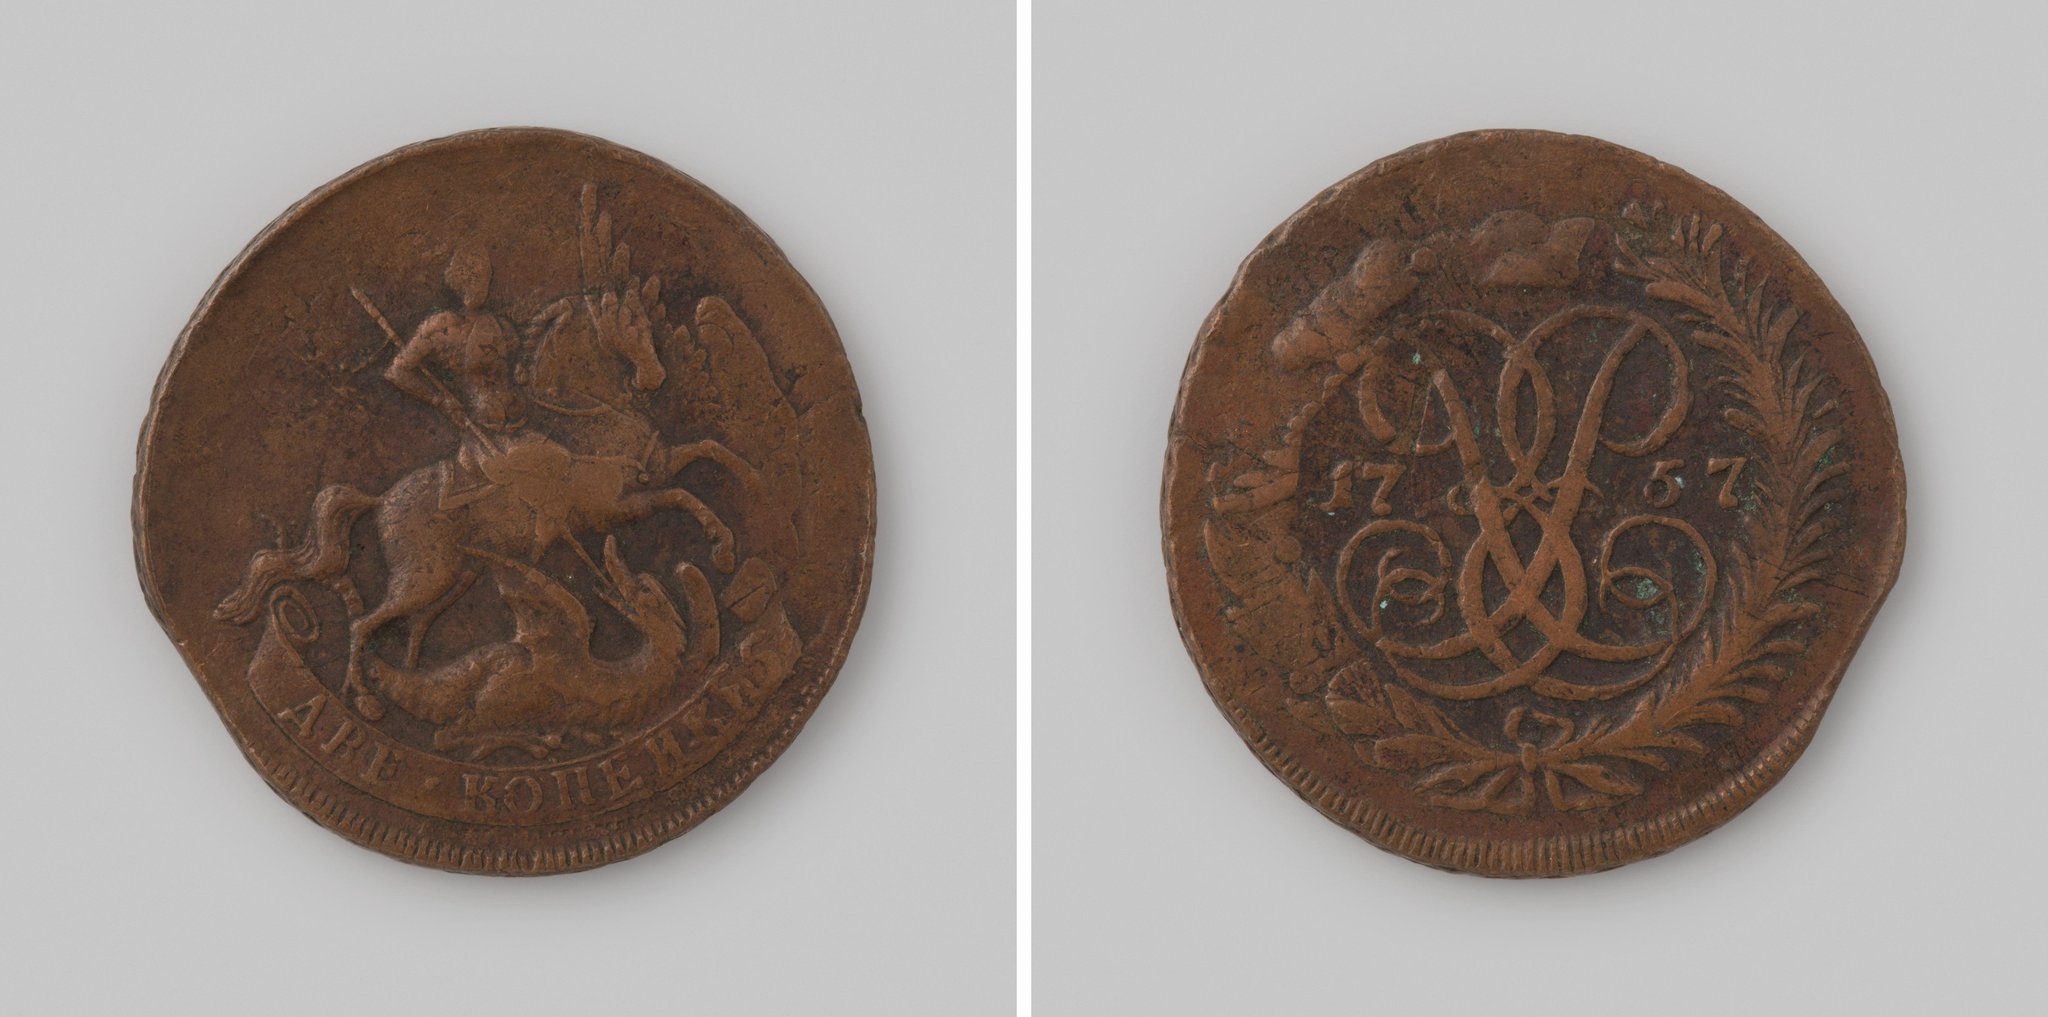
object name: coin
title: Rusland, tsarina Elisabeth I, 2 kopeken,1757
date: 1757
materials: copper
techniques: striking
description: Koperen munt. Voorzijde: Sint Joris te paard naar rechts die onderliggende draak steekt. Daaronder op een banderol waarde-aanduiding. Keerzijde: binnen twee samengebonden takken tussen het jaartal gekroond monogram van de czarina. Kabelrand.